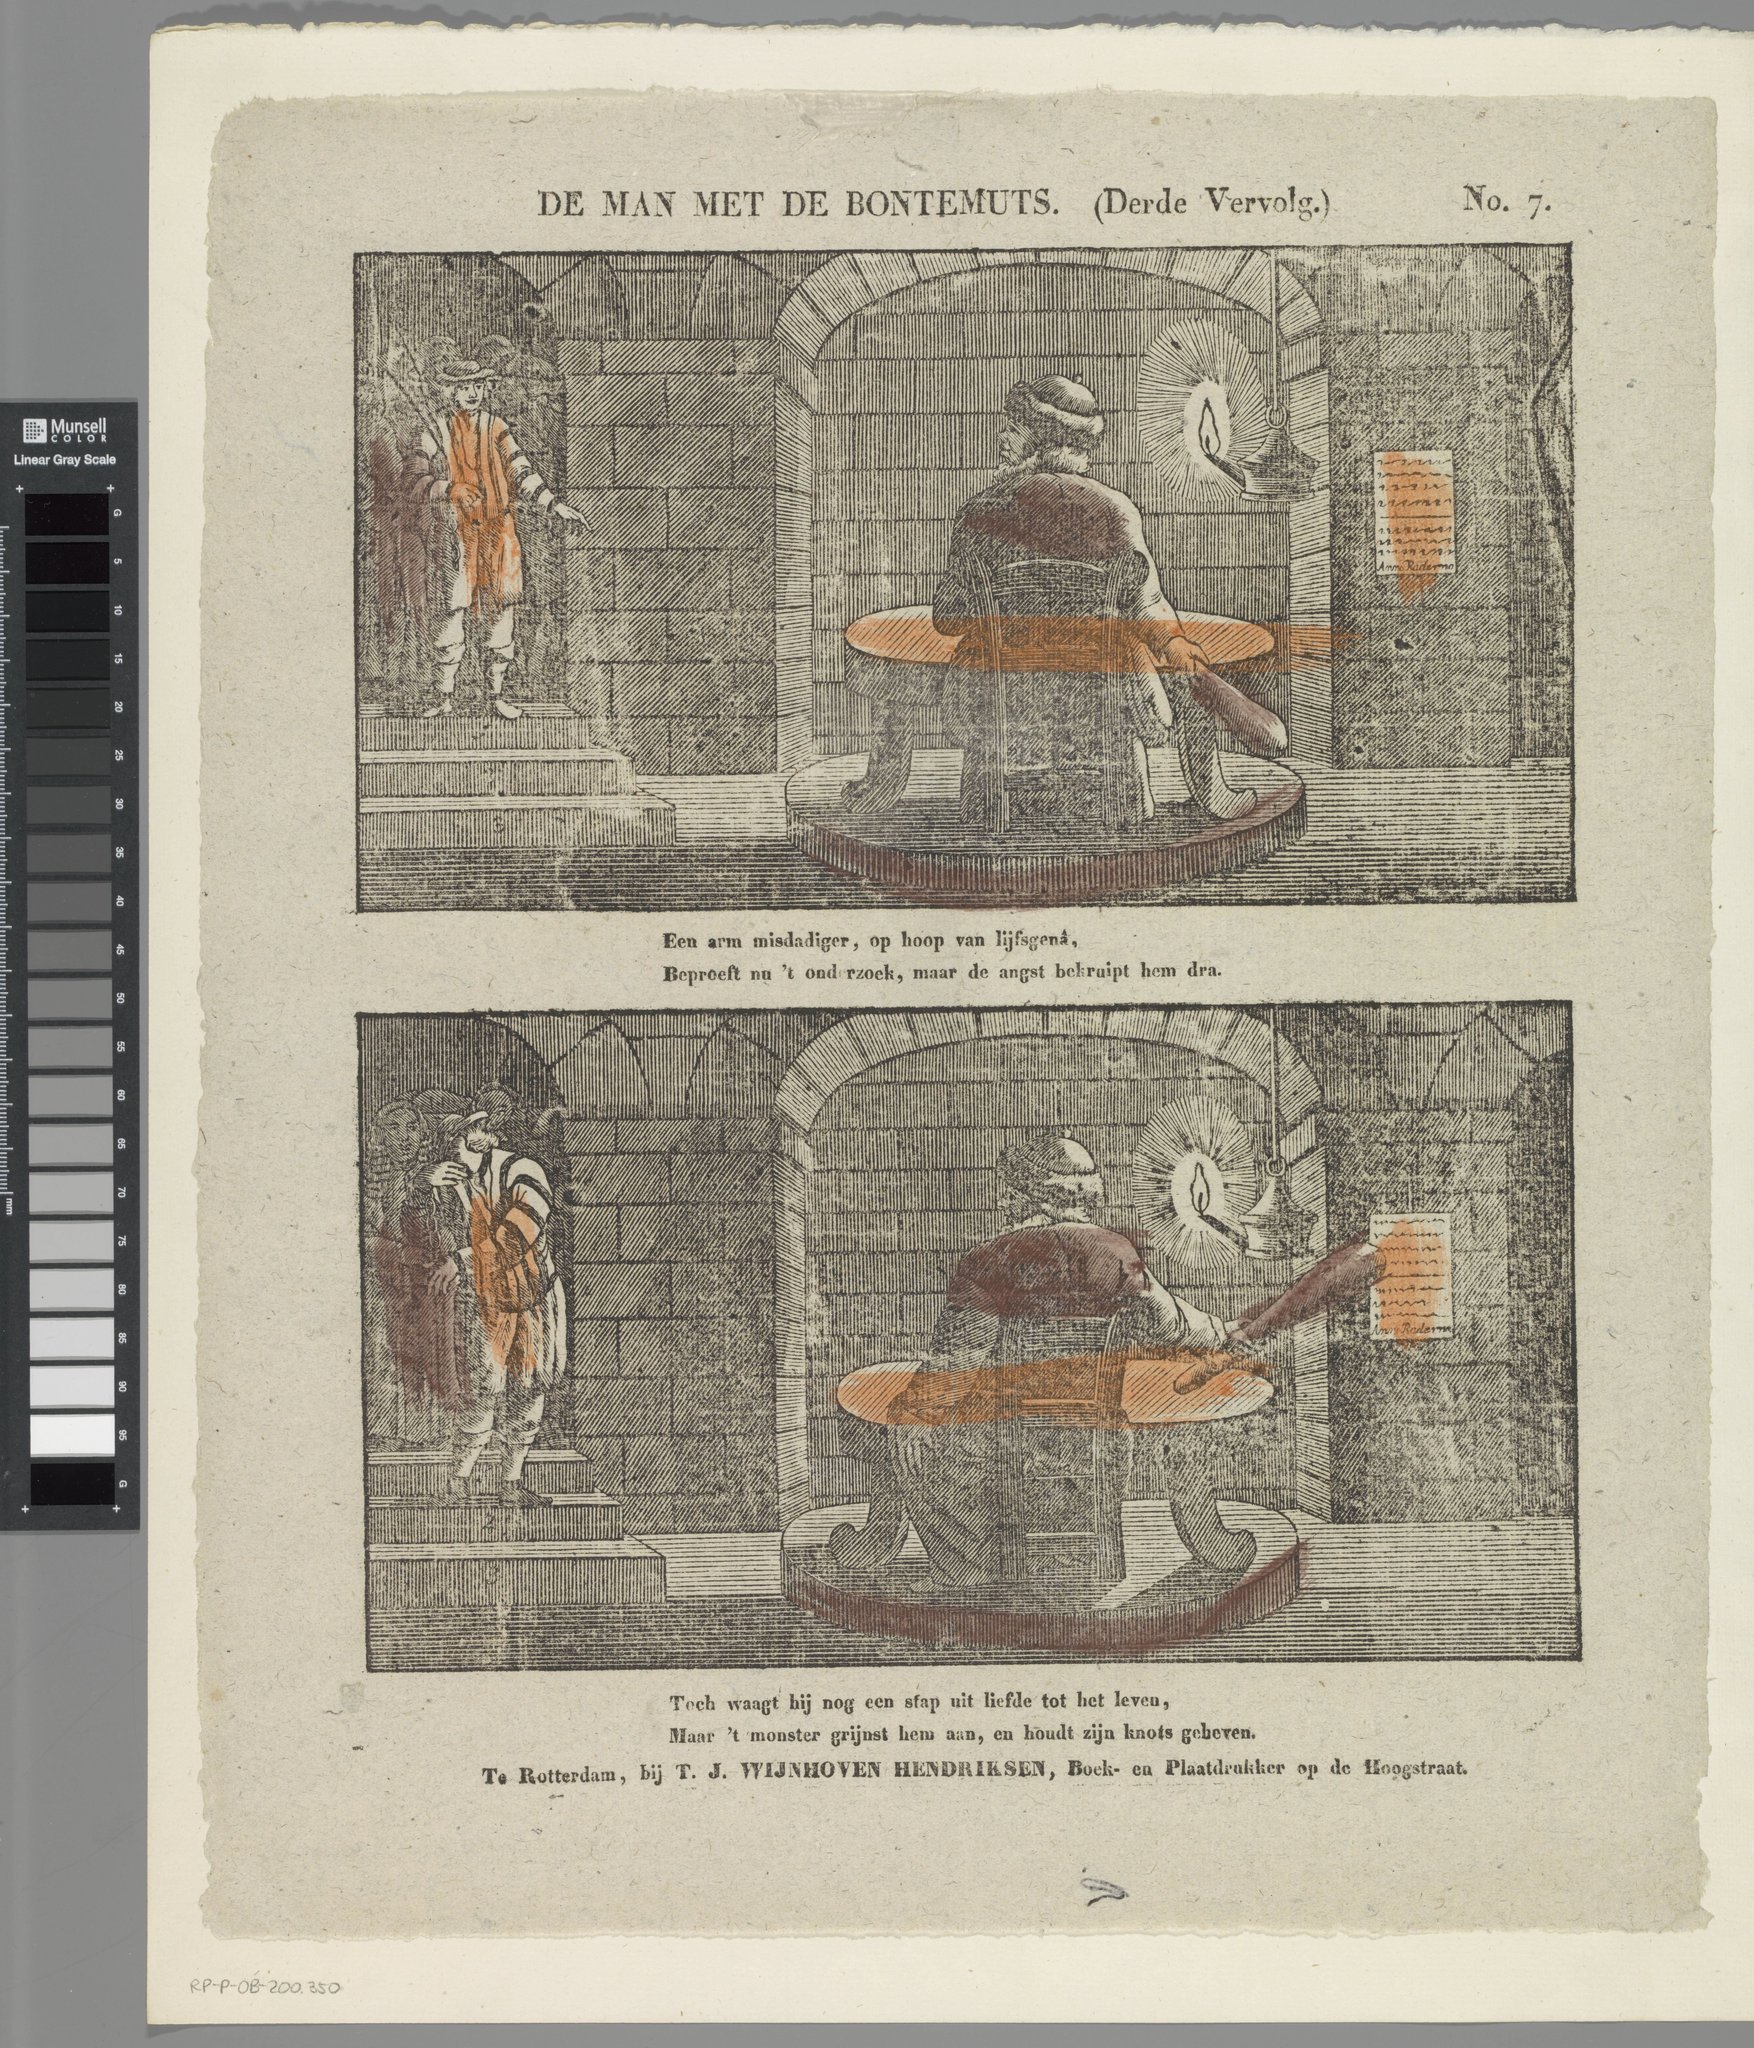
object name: popular print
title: De man met de bonte muts. / derde vervolg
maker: theodorus johannes wijnhoven-hendriksen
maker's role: publisher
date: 1832-1850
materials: paper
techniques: colour, letterpress printing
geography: rotterdam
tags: head-gear: hat (+ fur used for clothes), tales and fairy tales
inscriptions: collector's mark: Lugt 2760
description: Blad met 2 voorstellingen uit het verhaal van de man met de bontmuts. De erfgenamen van een oud kasteel ontdekken in een onderaardse gang een man met bontmuts op het hoofd die, achter een tafel gezeten, dreigt met een knuppel. Het blijkt evenwel dat het een houten pop is, welke in beweging gebracht wordt door het trappen op de treden die naar het onderaardse verblijf leiden. Onder elke voorstelling een tweeregelig vers. Genummerd rechtsboven: No. 7.